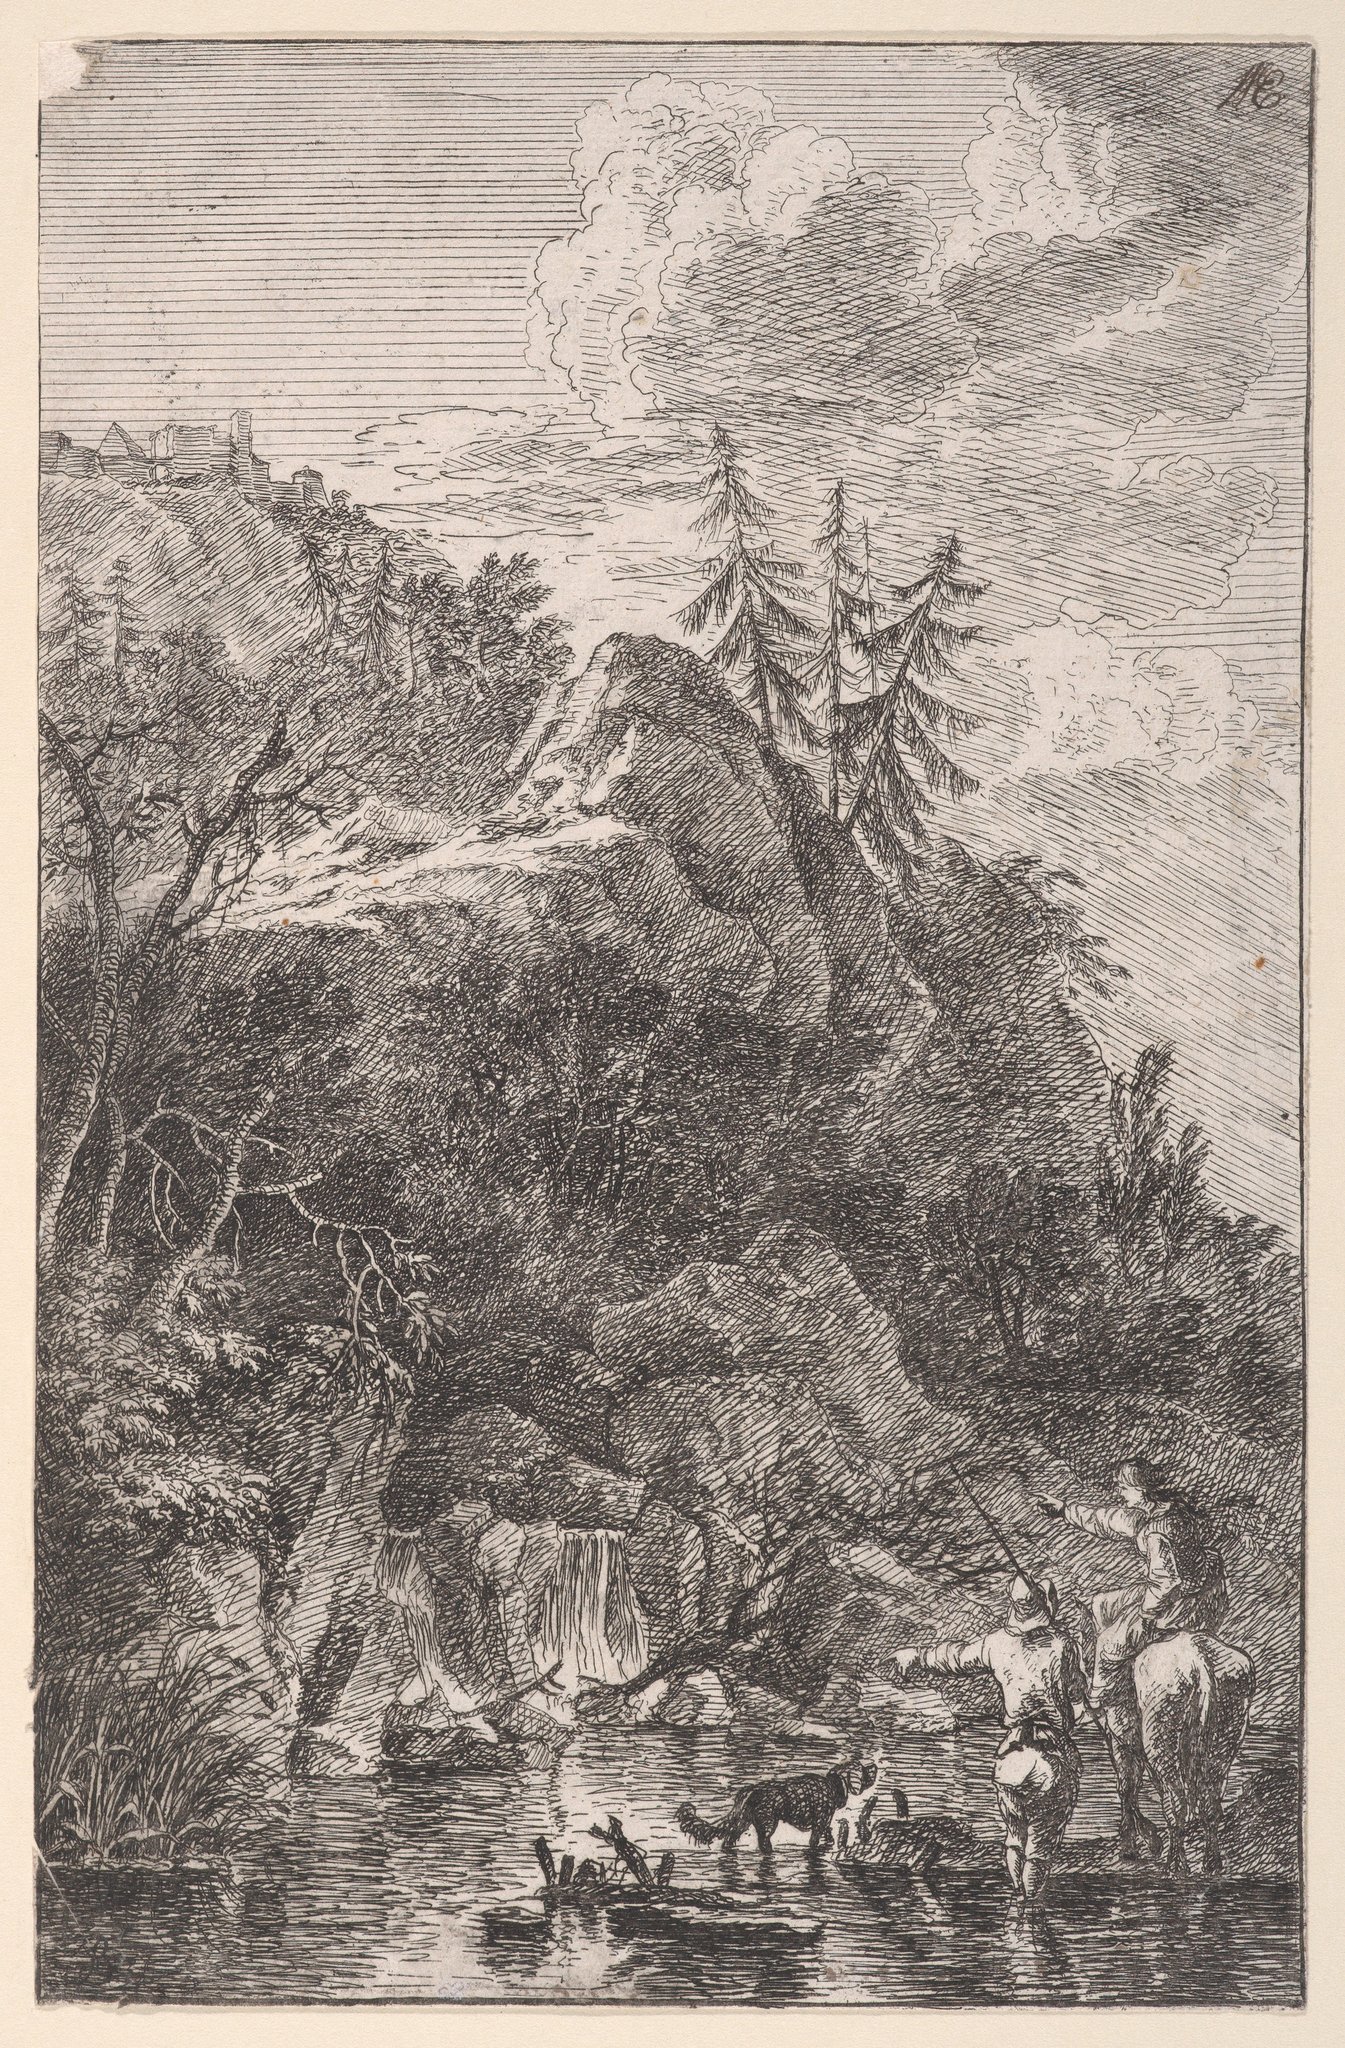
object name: print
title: Plate 5: female figure on horseback and a male figure with a dog standing in a stream, pointing to a waterfall at left in the background, from 'Landscapes in the manner of Salvator Rosa' (Die Landschaften in Sal. Rosa's)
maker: franz joachim beich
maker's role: artist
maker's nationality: german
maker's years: 1665-1745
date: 1700-1725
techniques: etching